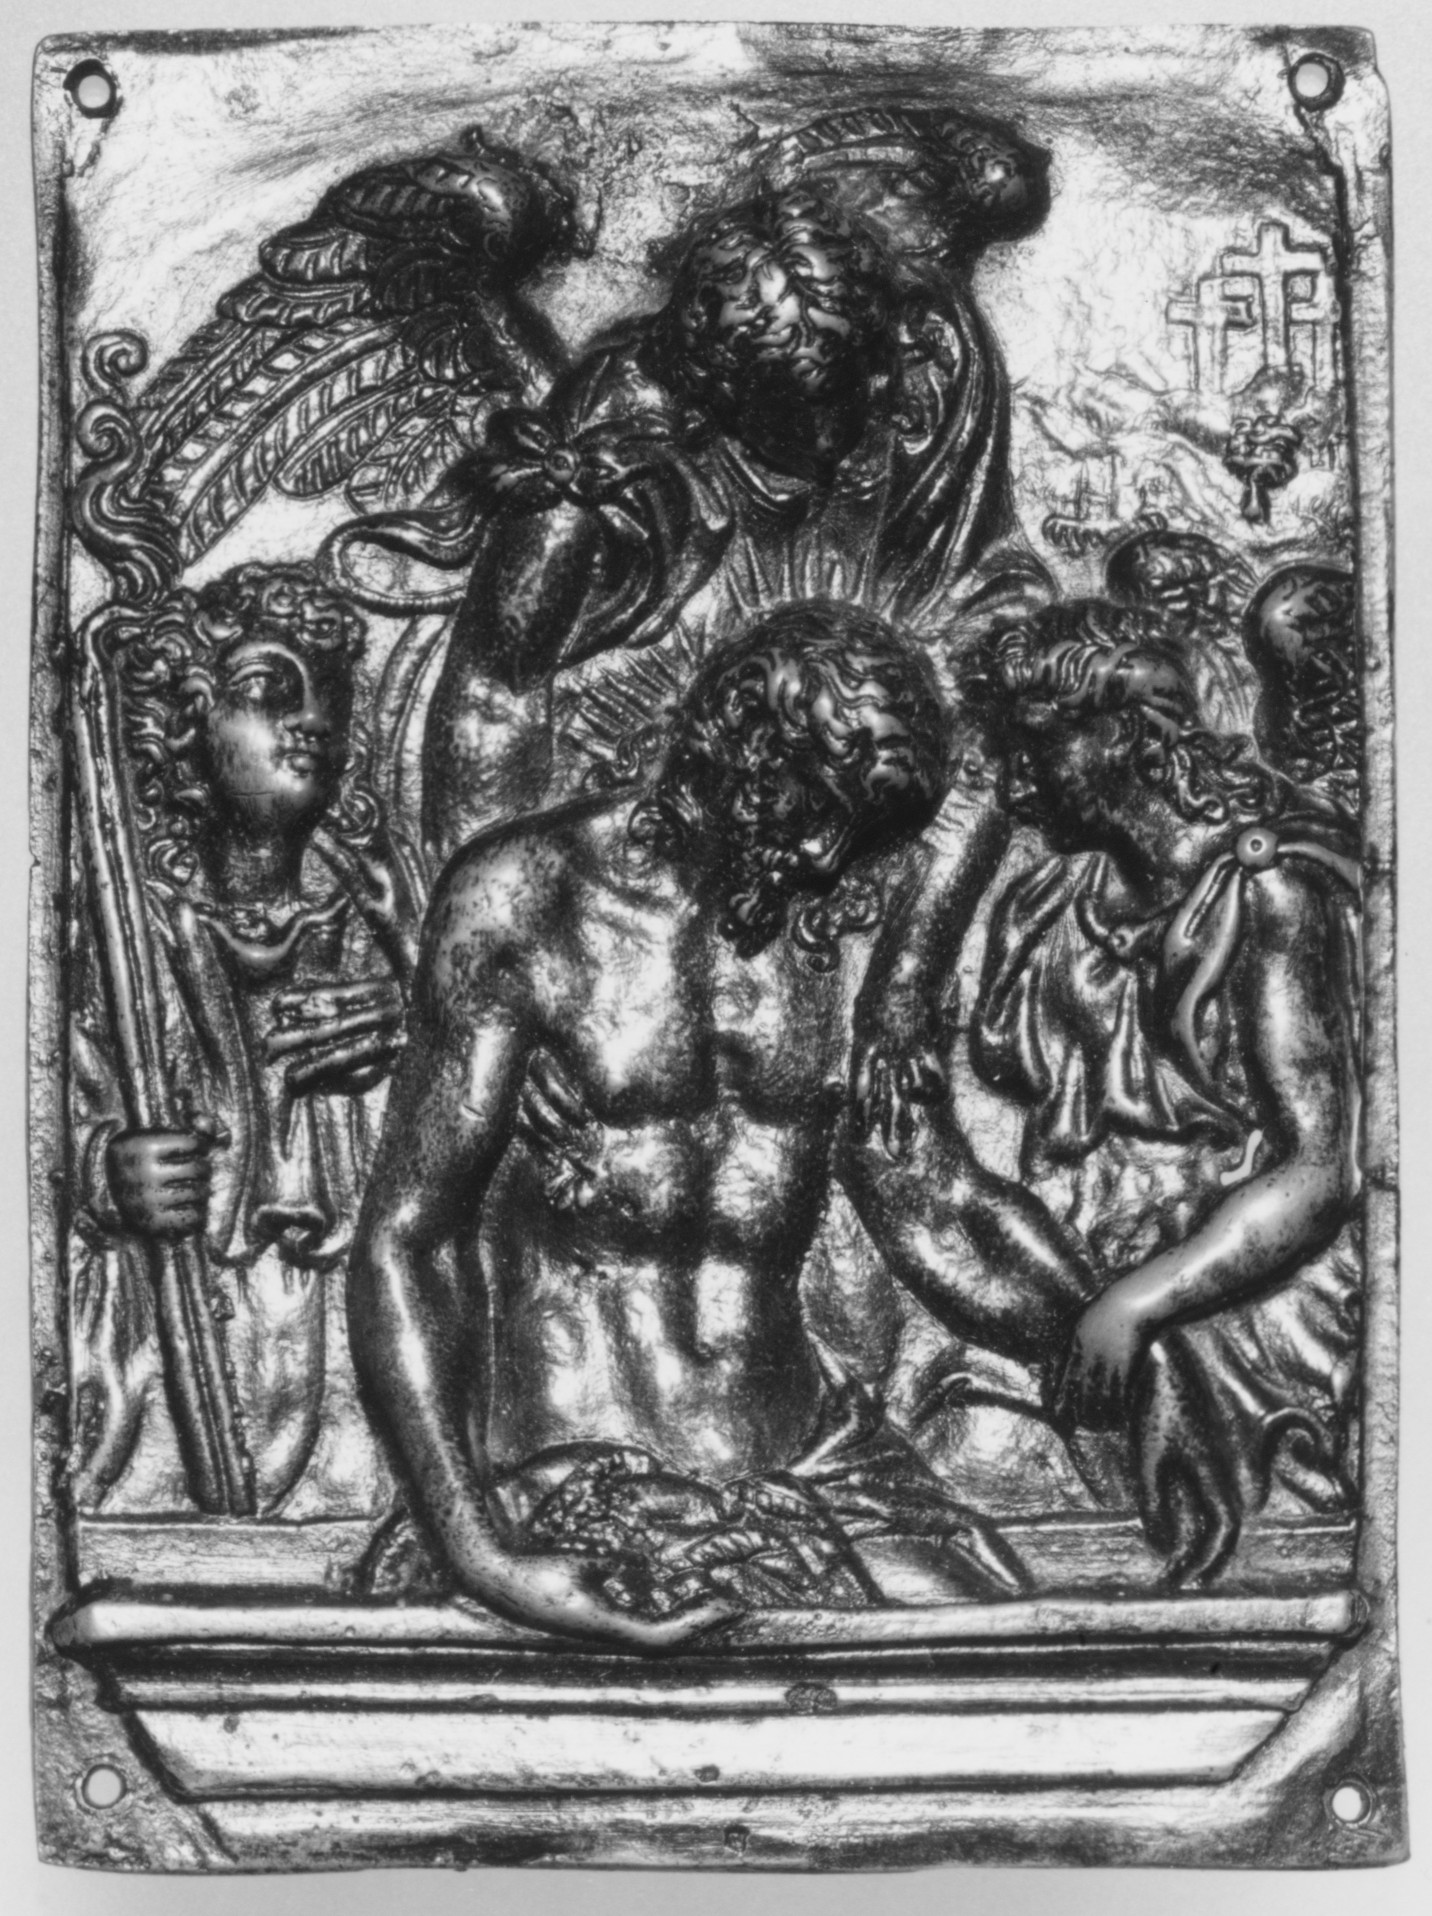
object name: plaquette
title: The Lamentation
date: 1501-1600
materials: bronze, lacquer, patina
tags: christ,lamentation